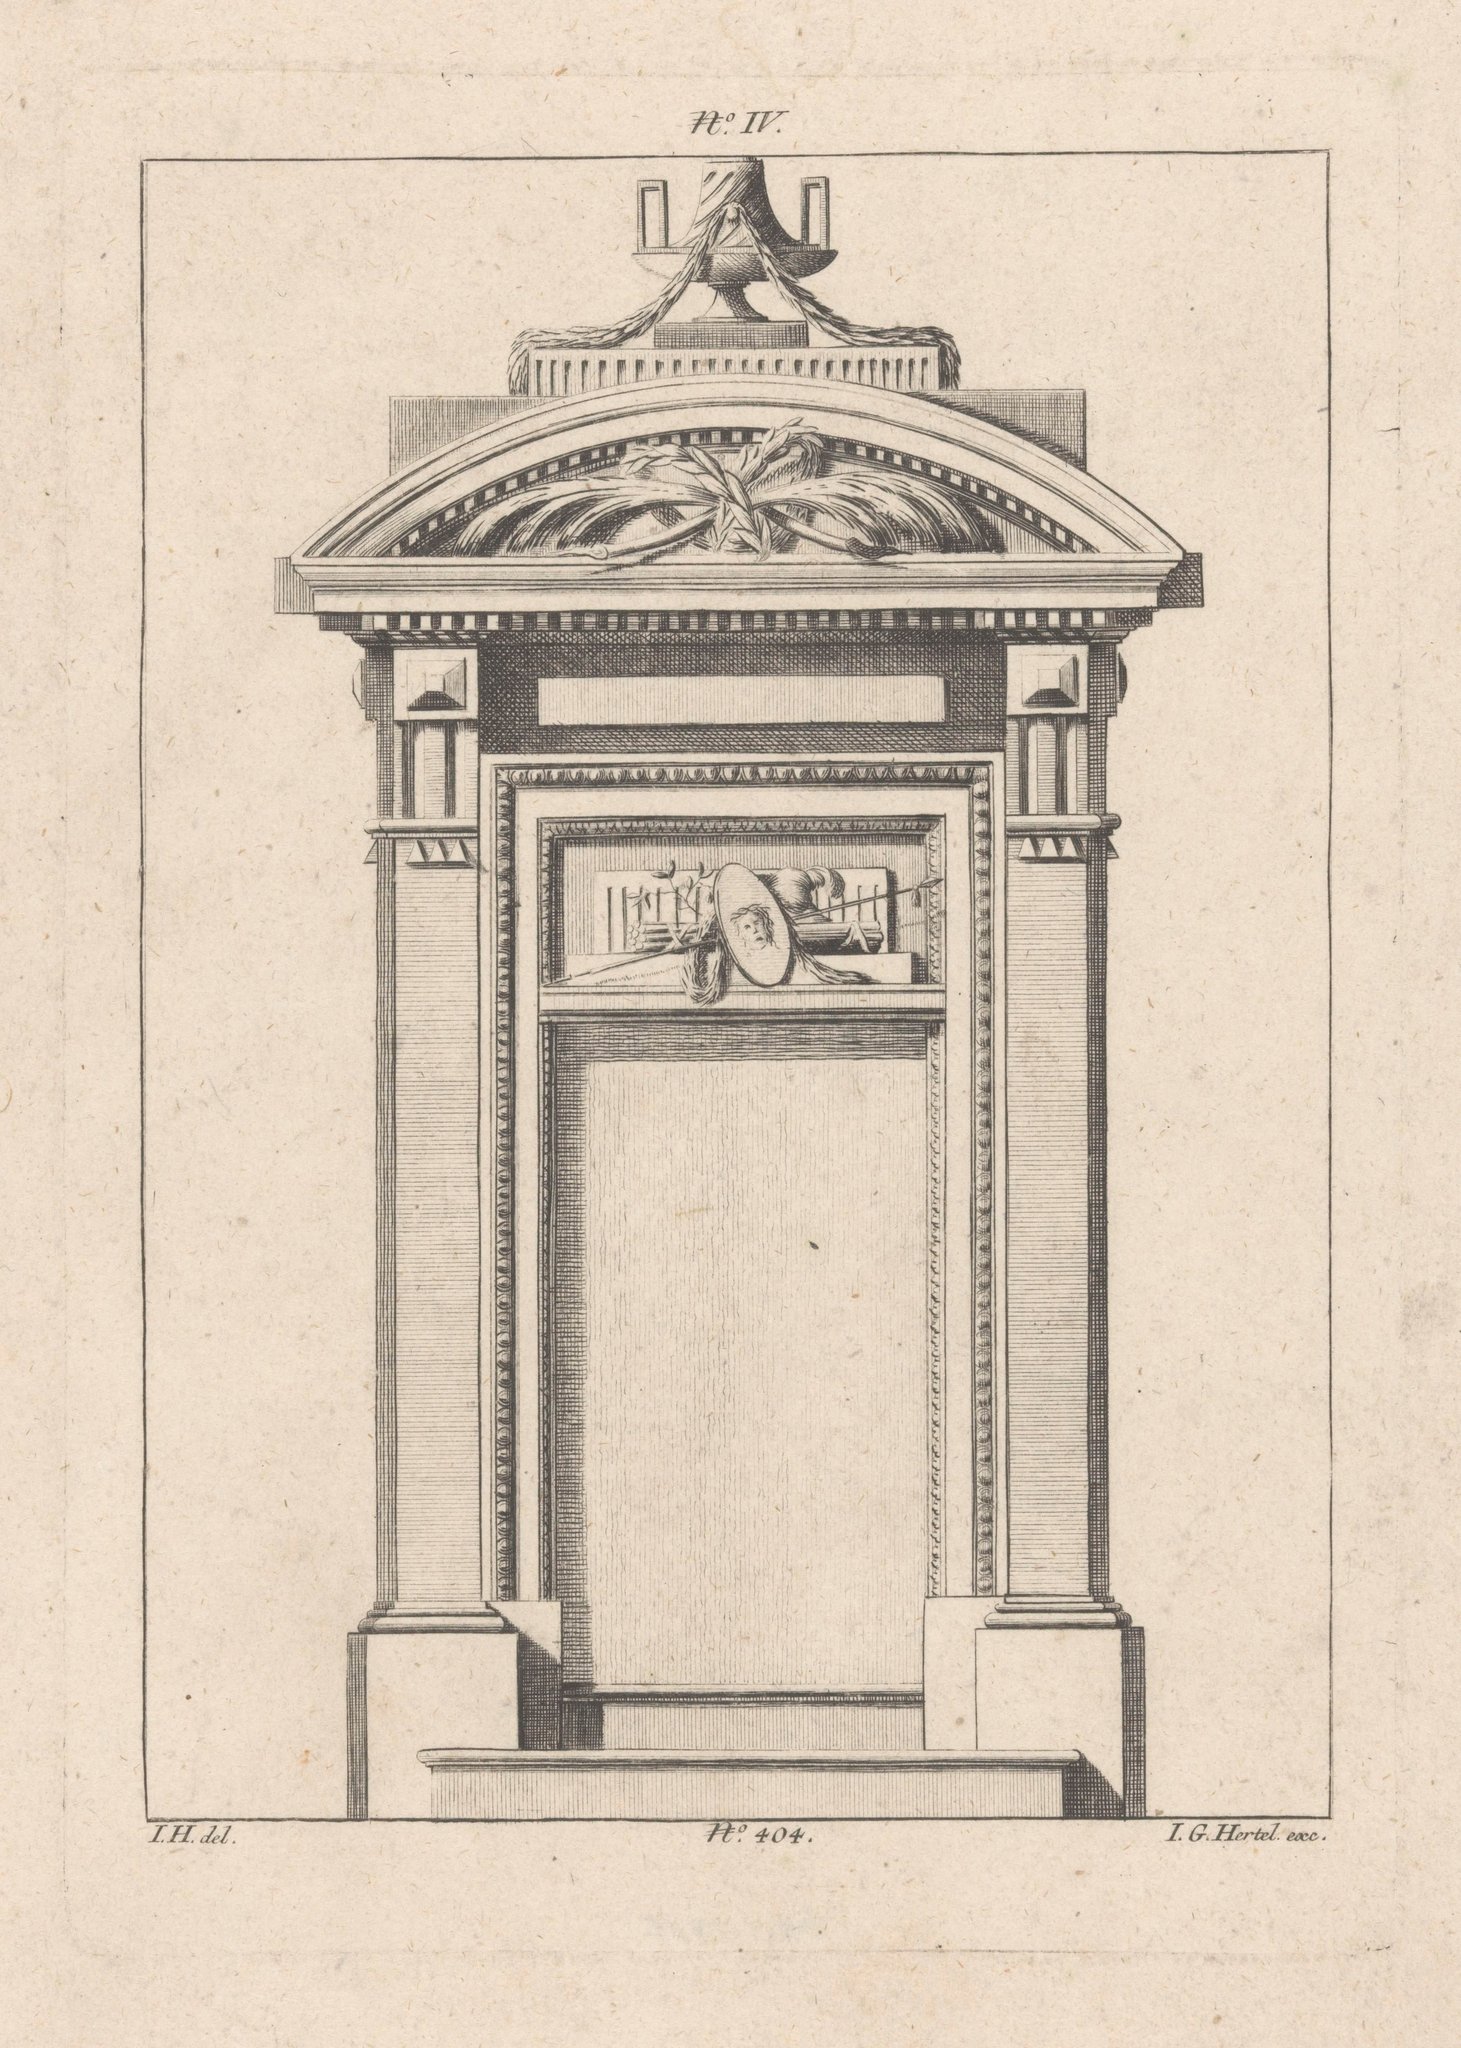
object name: ornament print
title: Portalen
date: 1770-1788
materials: paper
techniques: engraving, etching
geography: augsburg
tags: monumental door, porch, 'aediculum', vase ~ ornament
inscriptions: collector's mark: Lugt 2760, collector's mark: Lugt 2228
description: Ontwerp voor een portaal met segmentvormig fronton met palmtakken en laurierkransen. Daaronder een schild met kop, een laurierkrans en een lans. Het portaal wordt bekroond door een vaas met guirlandes. Uitgeversnummer 404.